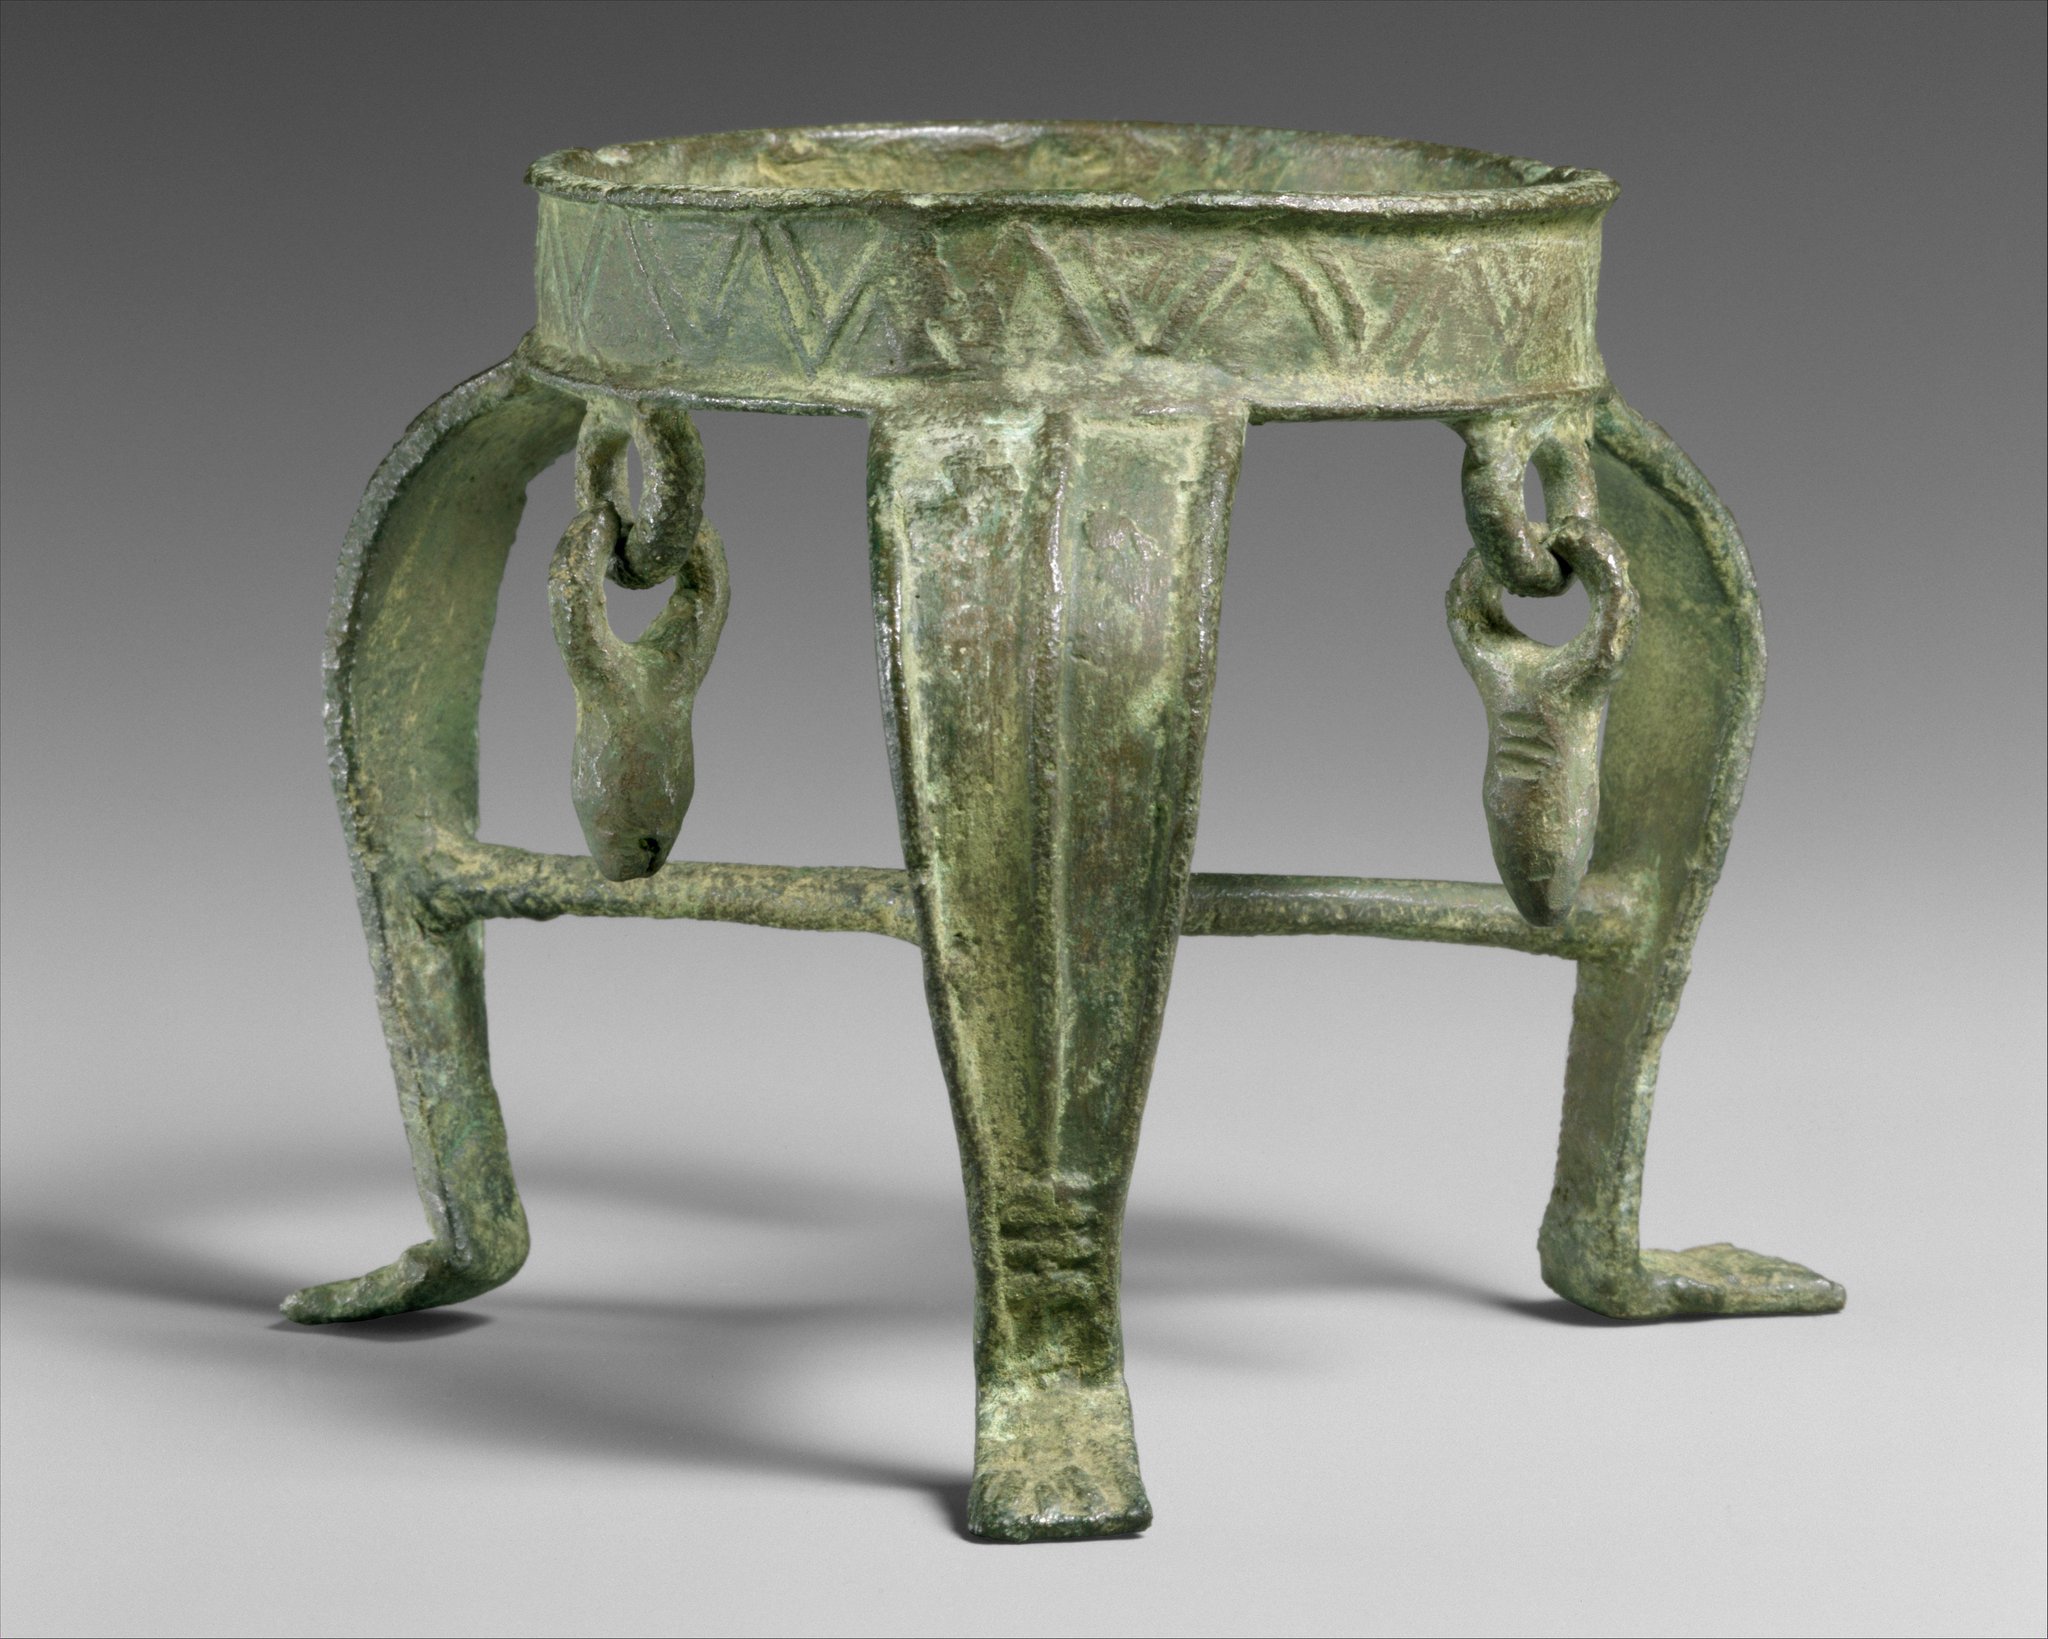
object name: tripod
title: Bronze tripod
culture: cypriot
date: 1450-1050 BCE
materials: bronze